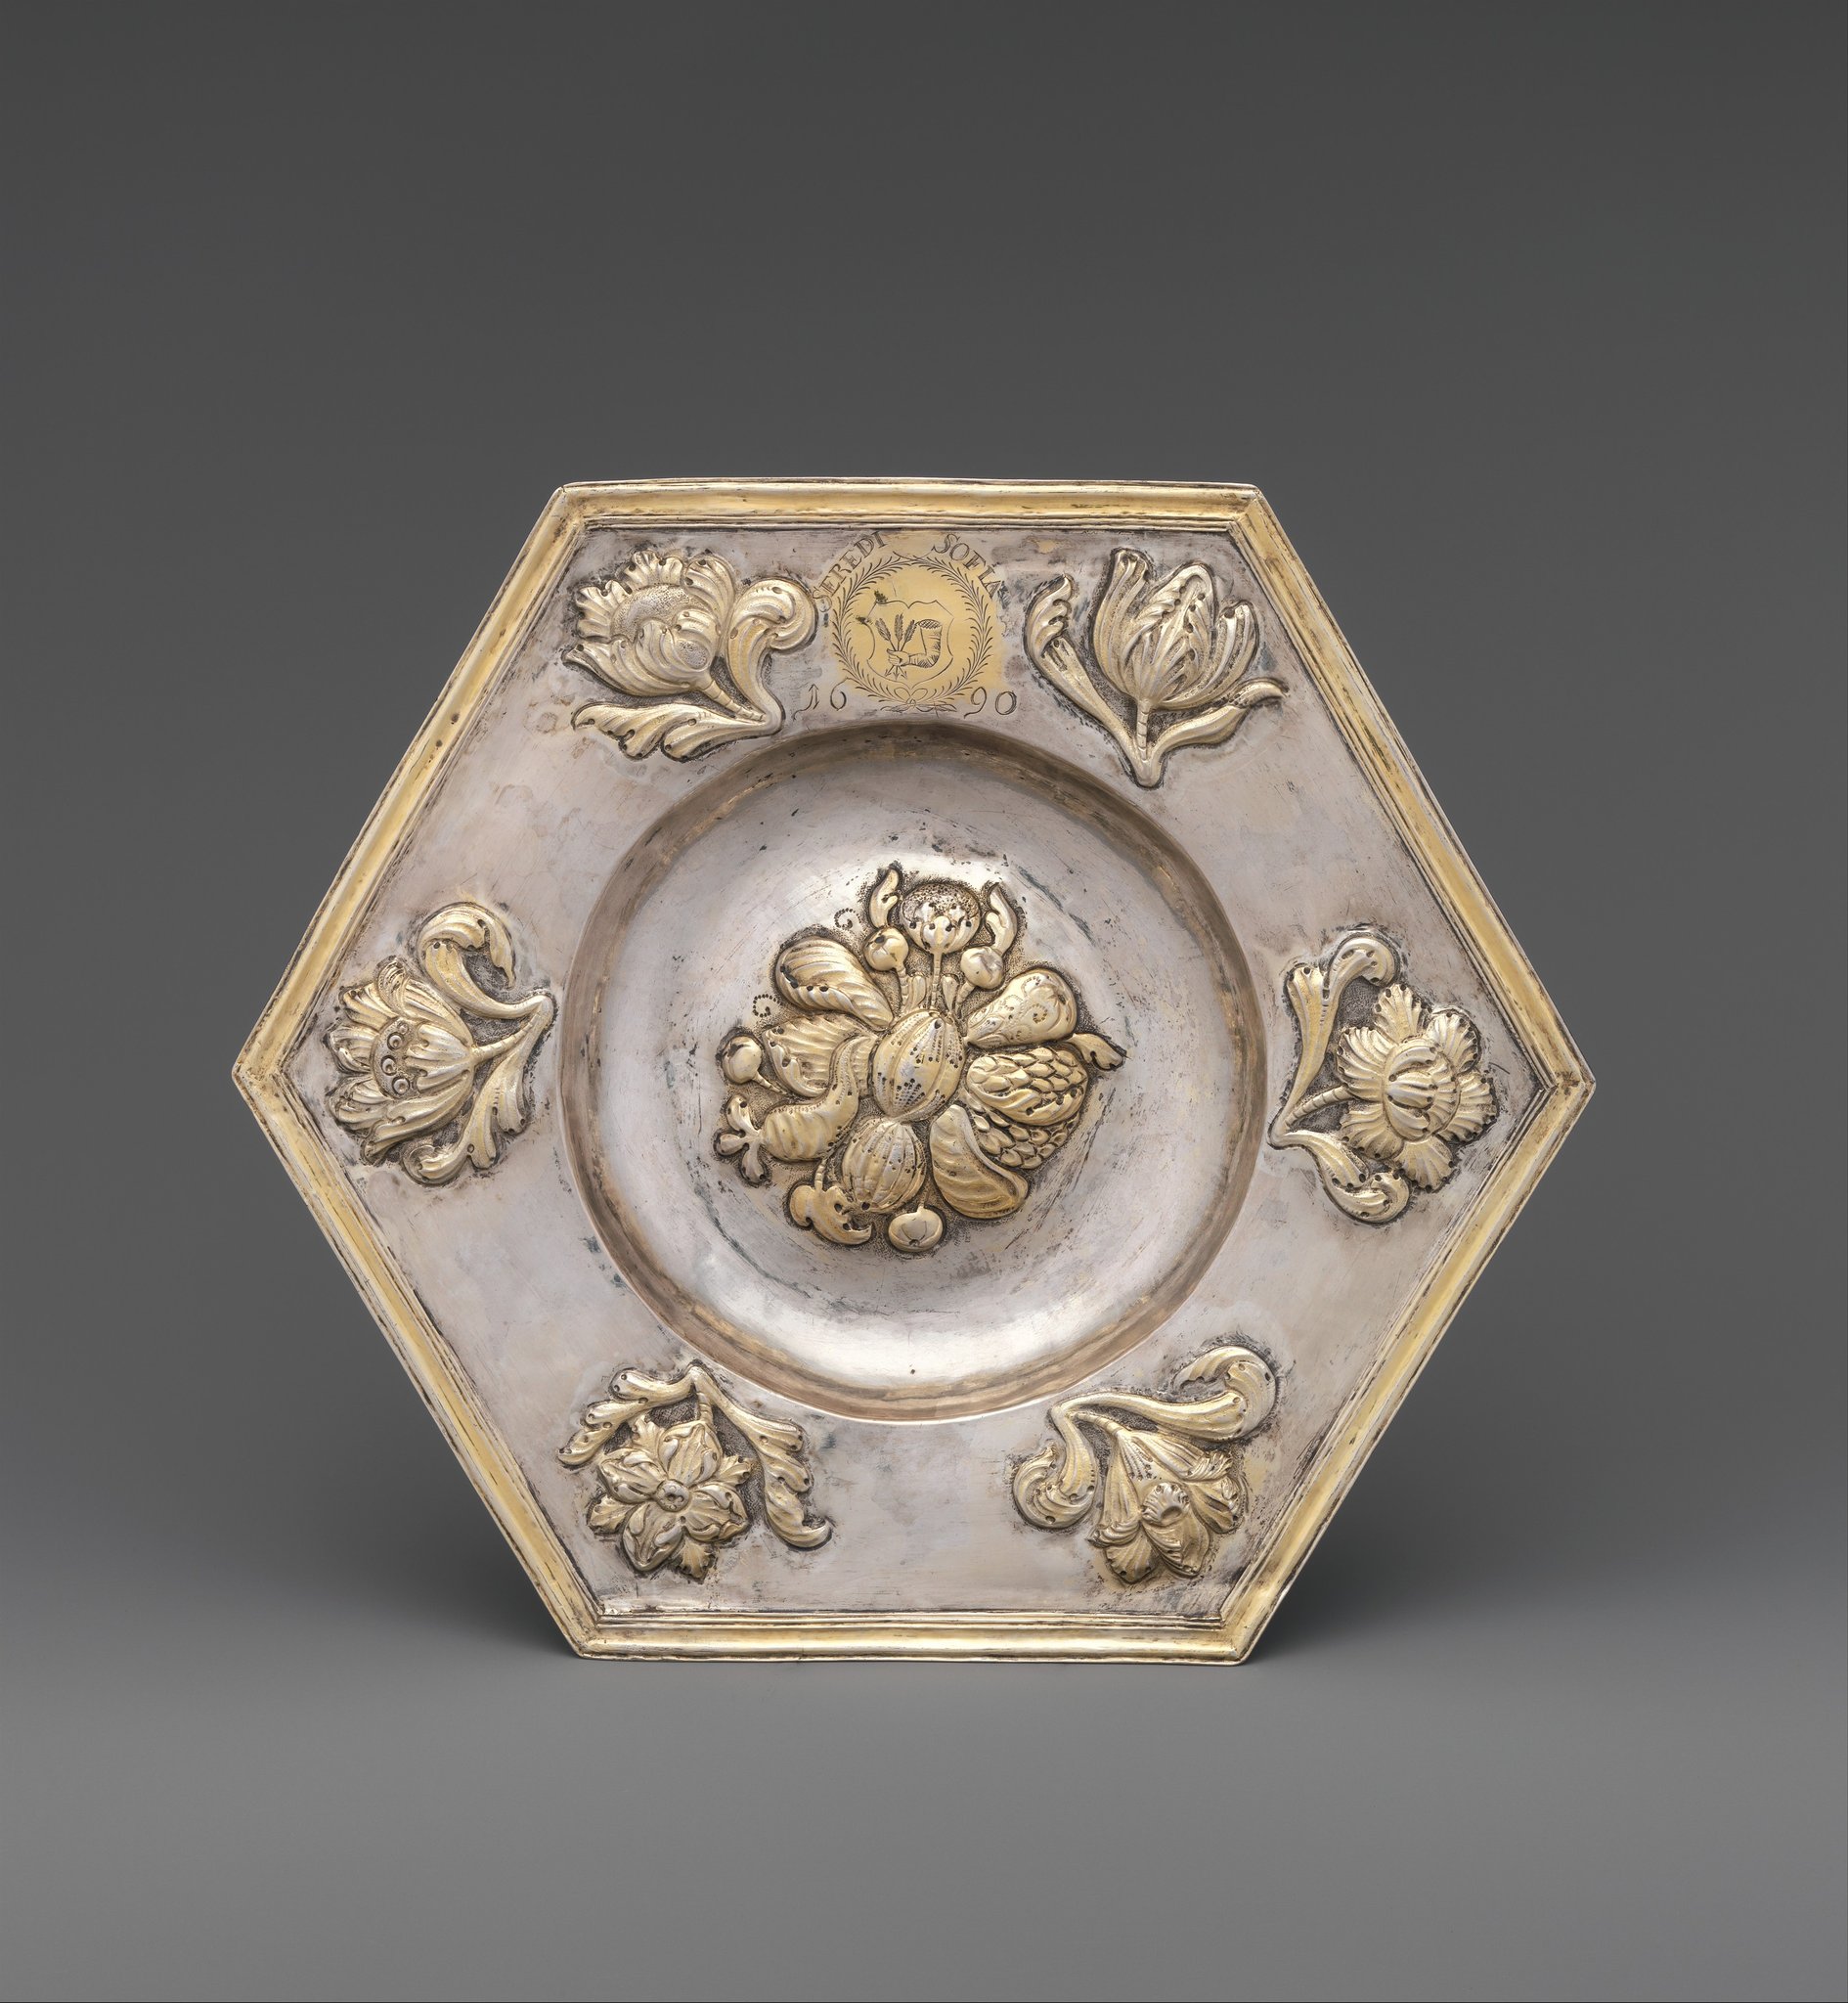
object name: dish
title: Dish (one of a pair)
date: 1634-1666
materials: silver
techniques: gilding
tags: flowers,wreaths,coat of arms